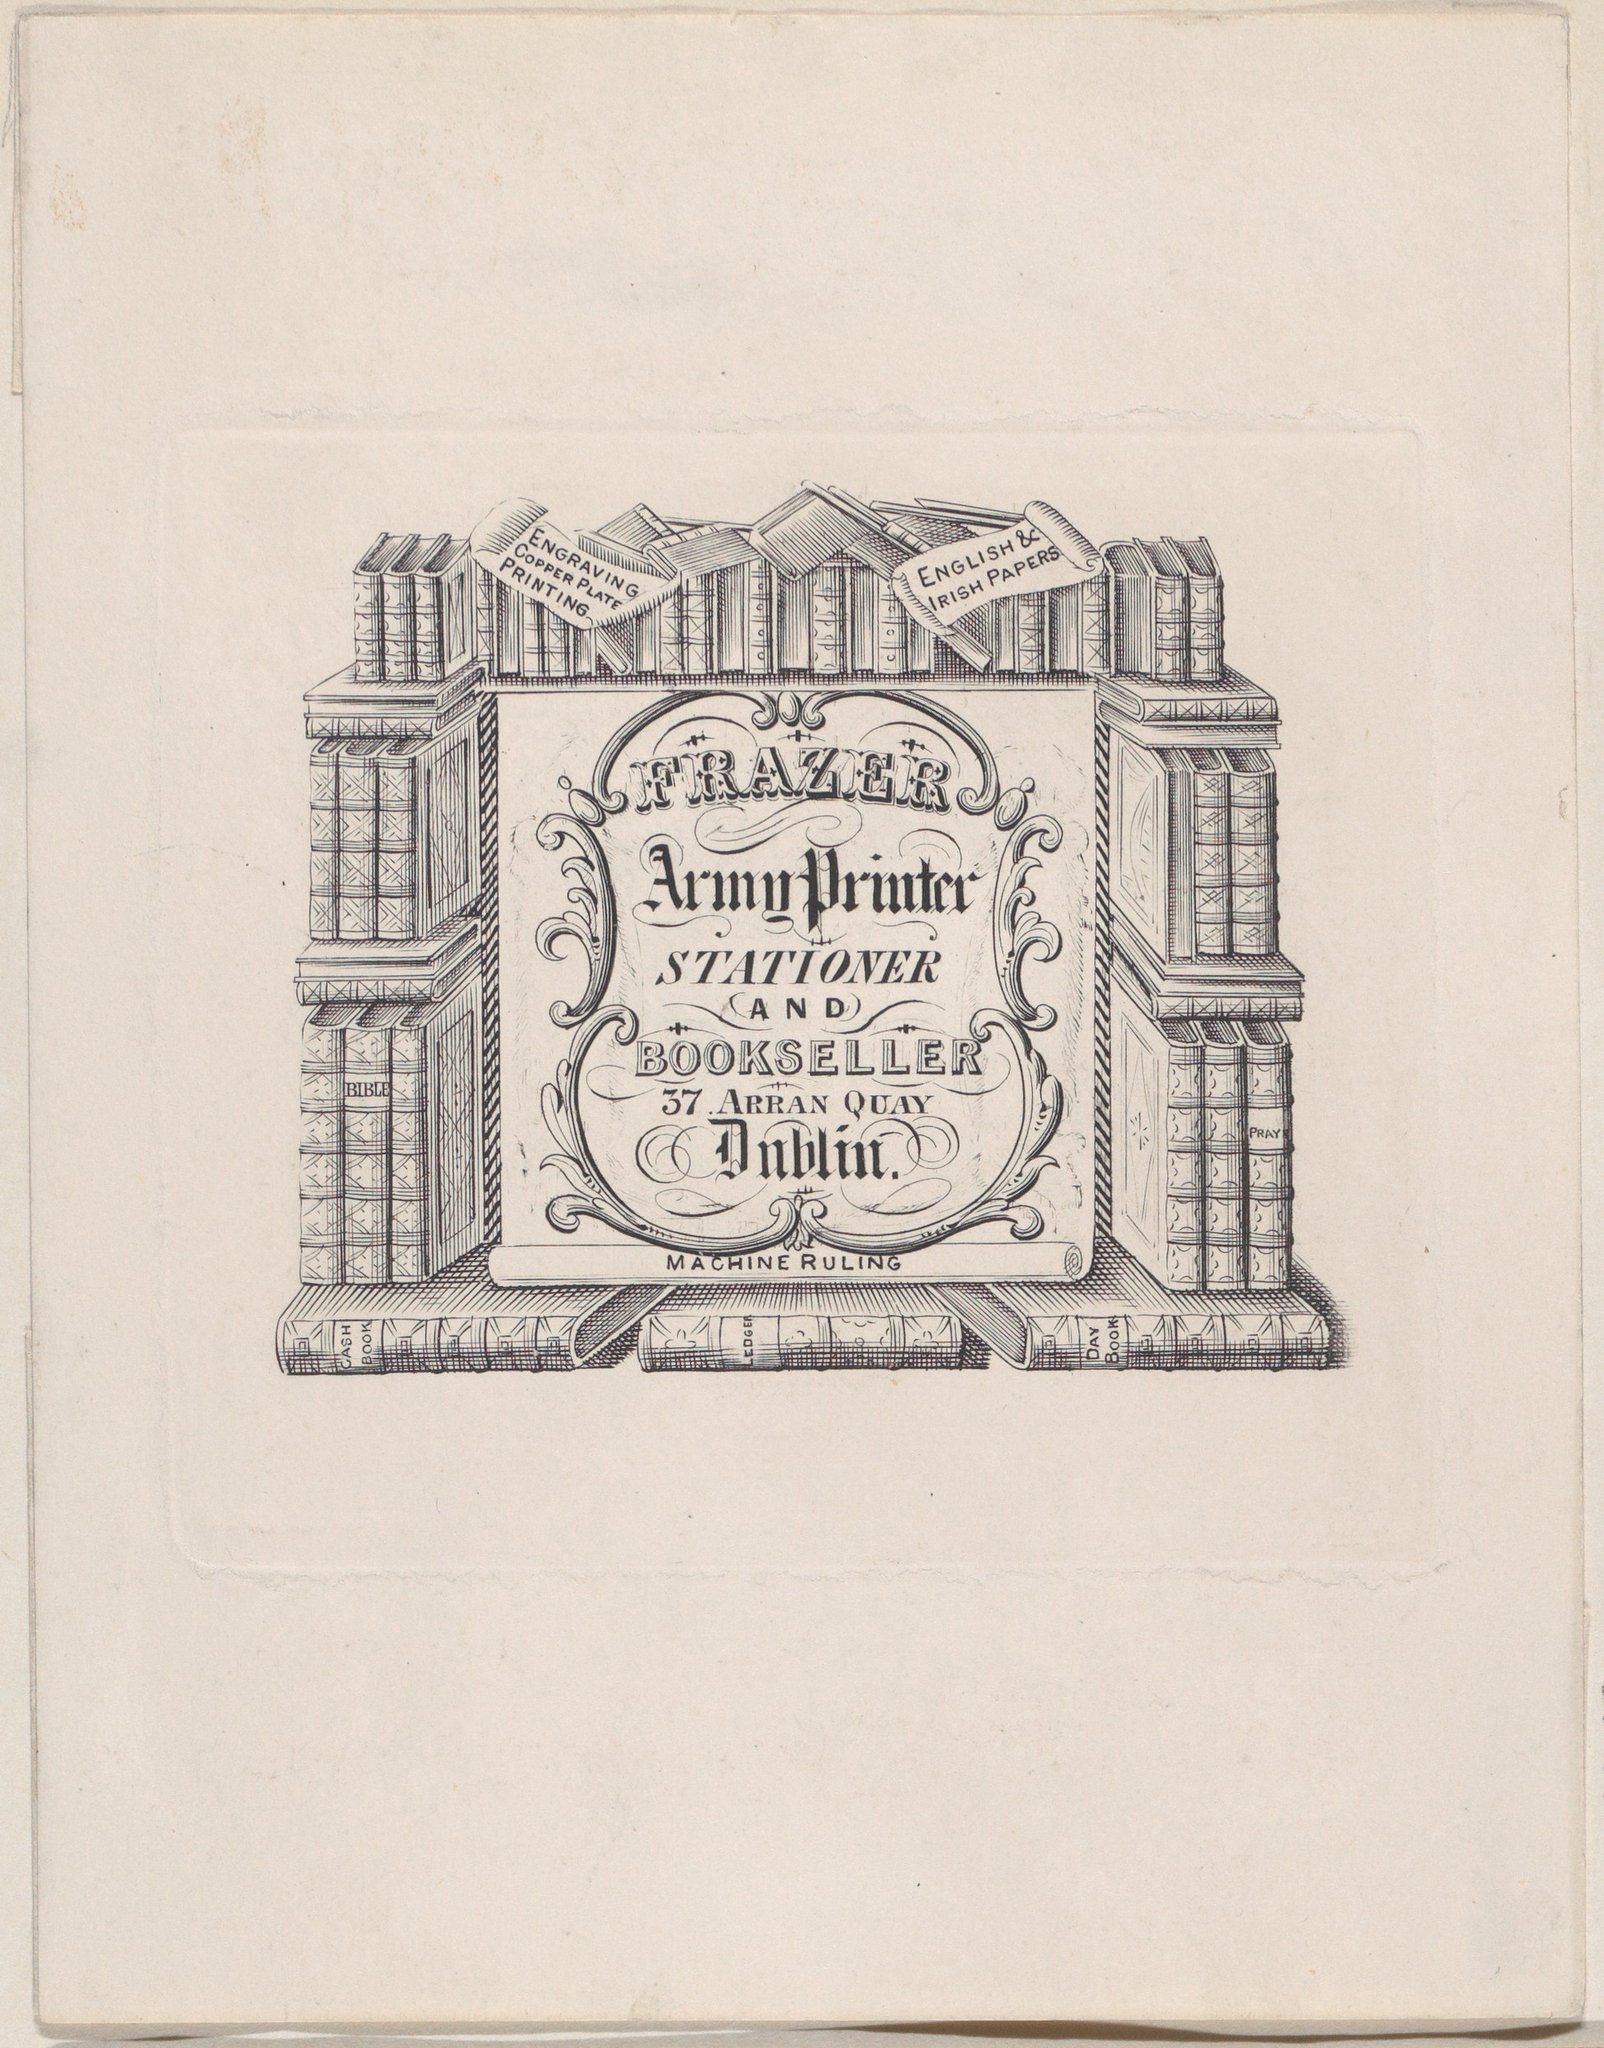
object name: print, trade card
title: Trade Card for Frazer, Army Printer and Stationer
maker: anonymous, irish, 19th century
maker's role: artist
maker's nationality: irish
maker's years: 1800-1900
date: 1801-1900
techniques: engraving